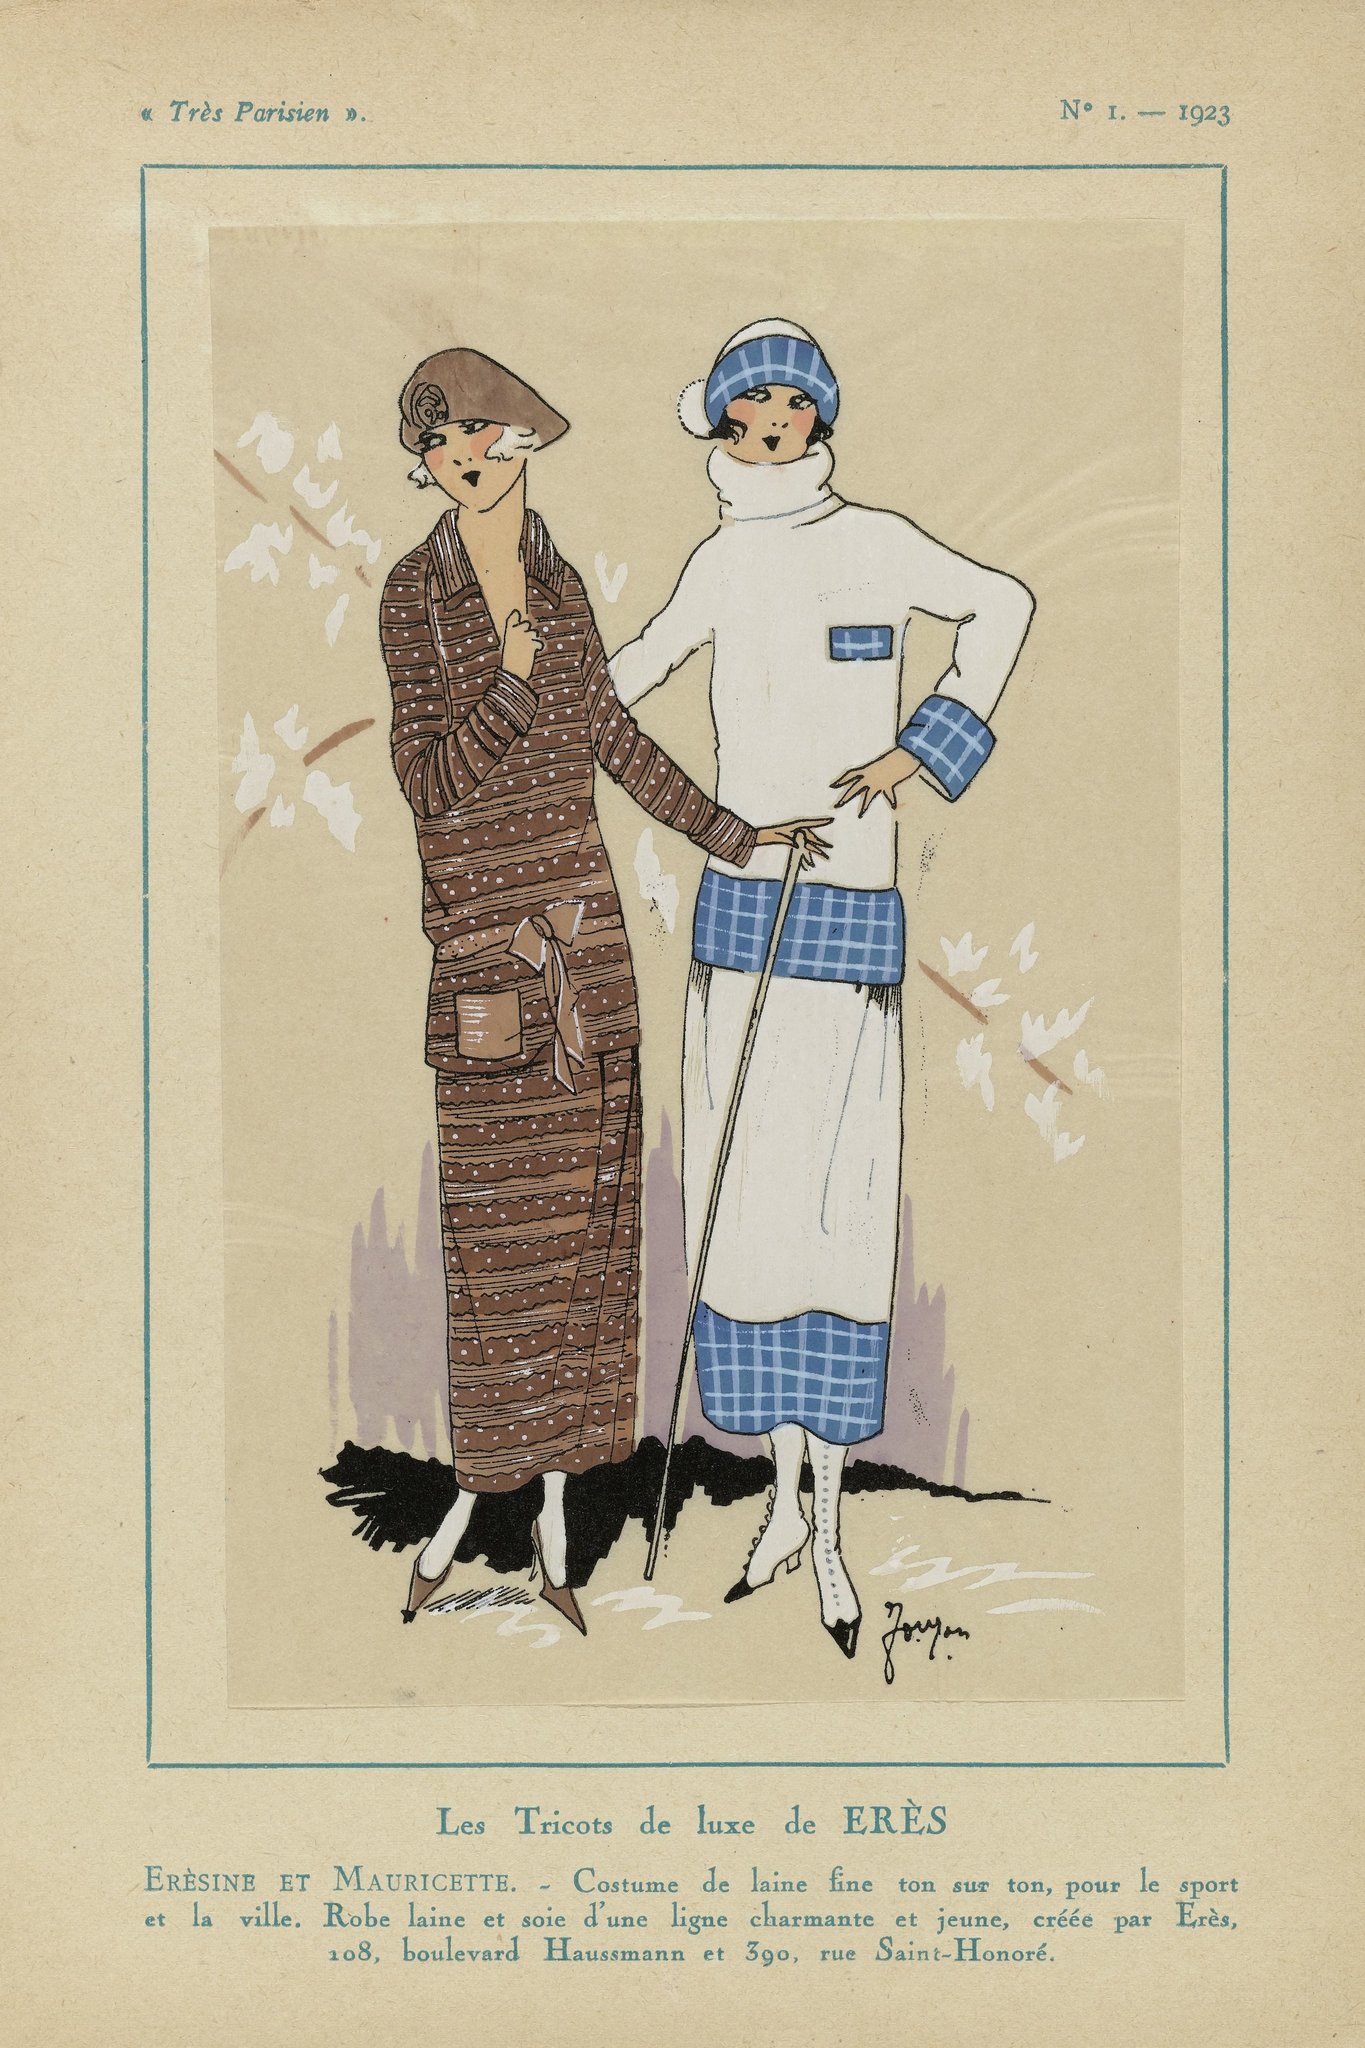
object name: fashion print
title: Très Parisien, 1923, No 1: Les Tricots de luxe de ERÈS...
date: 1923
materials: paper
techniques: hand coloring, letterpress printing, lithography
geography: paris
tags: clothing for the upper part of the body (+ women's clothes), walking-stick, staff, cane (+ women's clothes), head-gear: cap (+ women's clothes), fashion plates, head-gear: hat (+ women's clothes), skirt (+ women's clothes), dress, gown (+ women's clothes)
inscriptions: title: ‘Très Parisien / No 1. - 1923’, caption: ‘Les Tricots de luxe de ERÈS / ERÈSINE ET MAURICETTE. - Costume de laine fine ton sur ton, pour le sport et la ville. Robe laine et soie d'une ligne charmante et jeune, créée par Erès, 108, boulevard Haussmann et 390, rue Saint-Honoré.’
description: Sportief kostuum van fijne wol en een japon van wol en zijde voor de stad. Beide van Erès, 108, boulevard Haussmann et 390, rue Saint-Honoré. Prent uit het modetijdschrift Très Parisien (1920-1936).